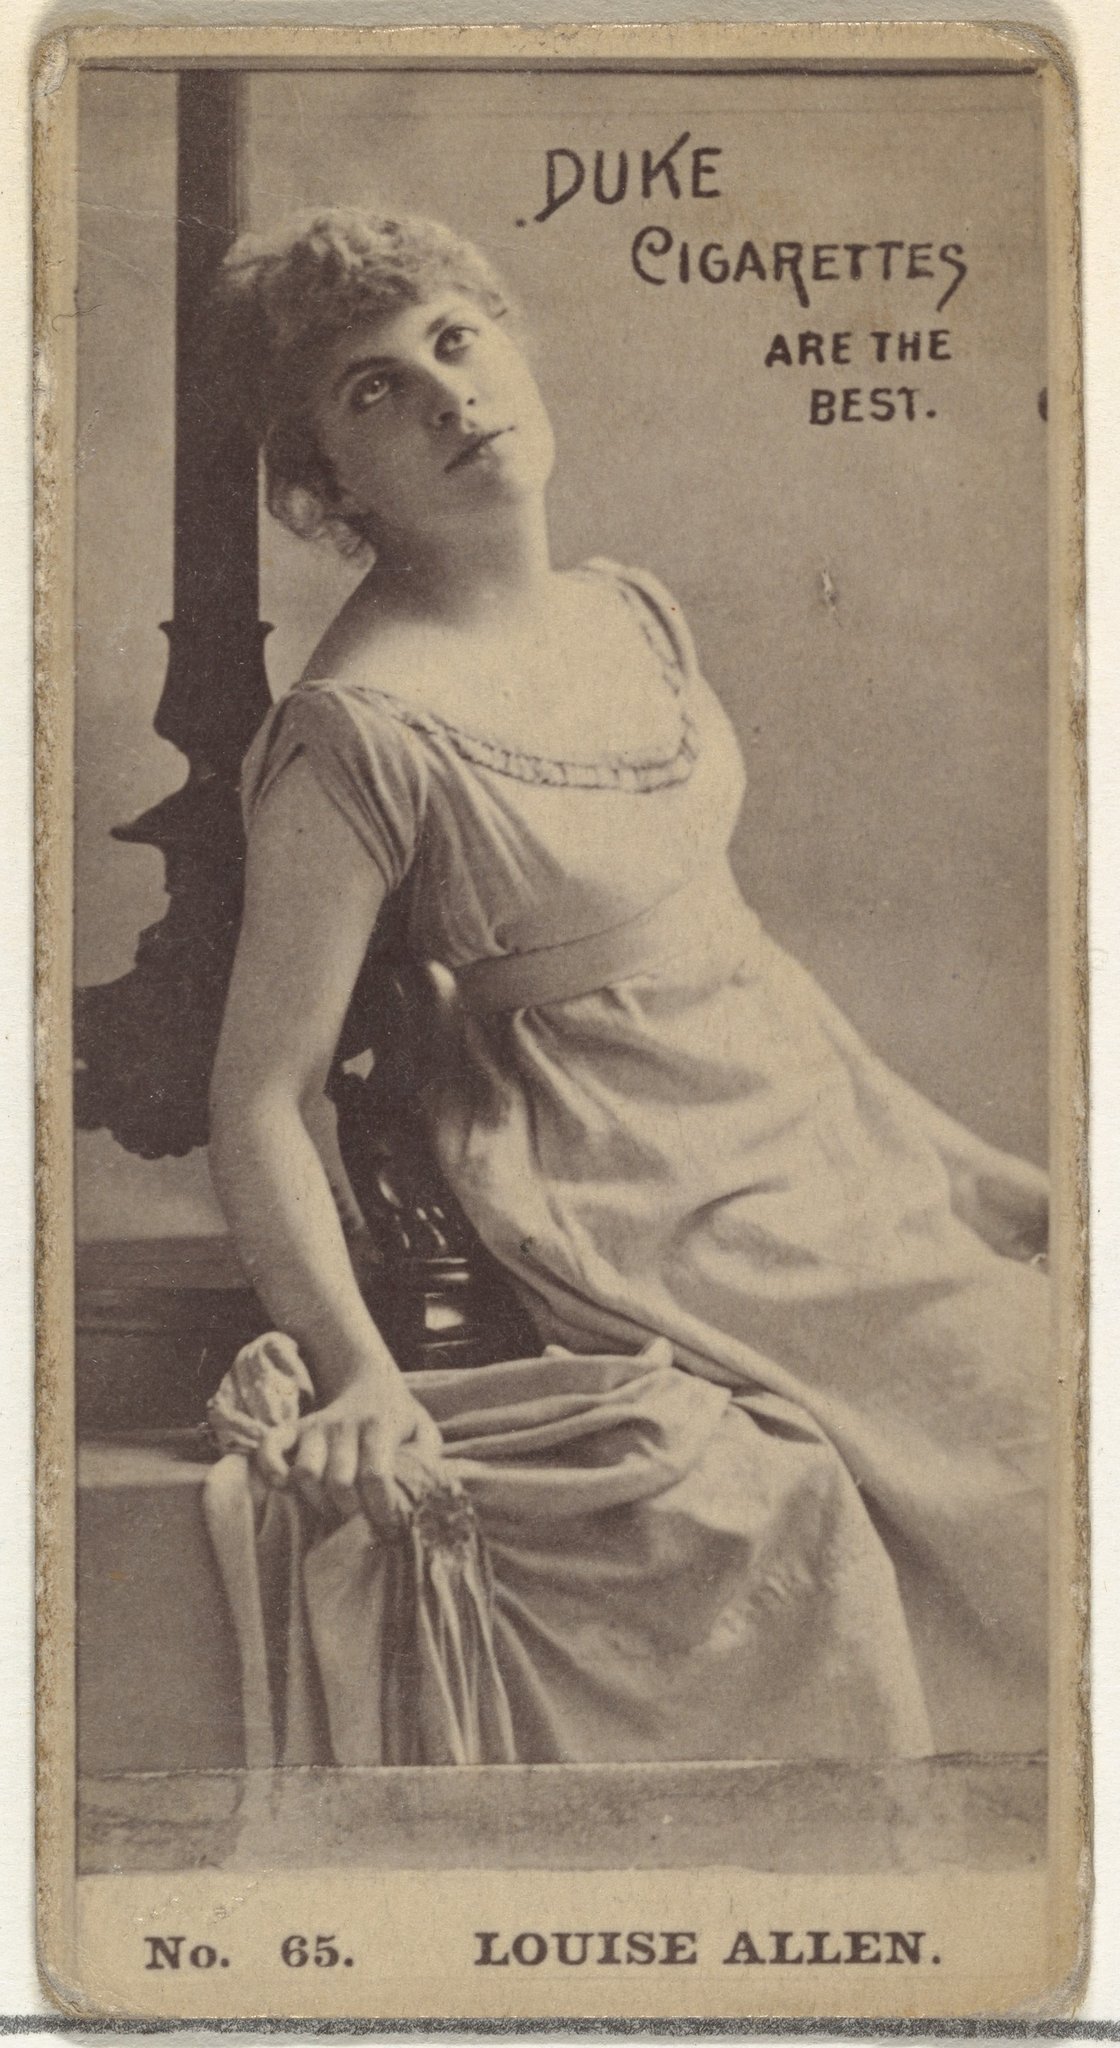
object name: photograph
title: Card Number 65, Louise Allen, from the Actors and Actresses series (N145-6) issued by Duke Sons & Co. to promote Duke Cigarettes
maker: w. duke, sons & co.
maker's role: publisher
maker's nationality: american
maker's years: 1870-1920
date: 1880-1889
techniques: albumen silver print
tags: portraits,women,actresses